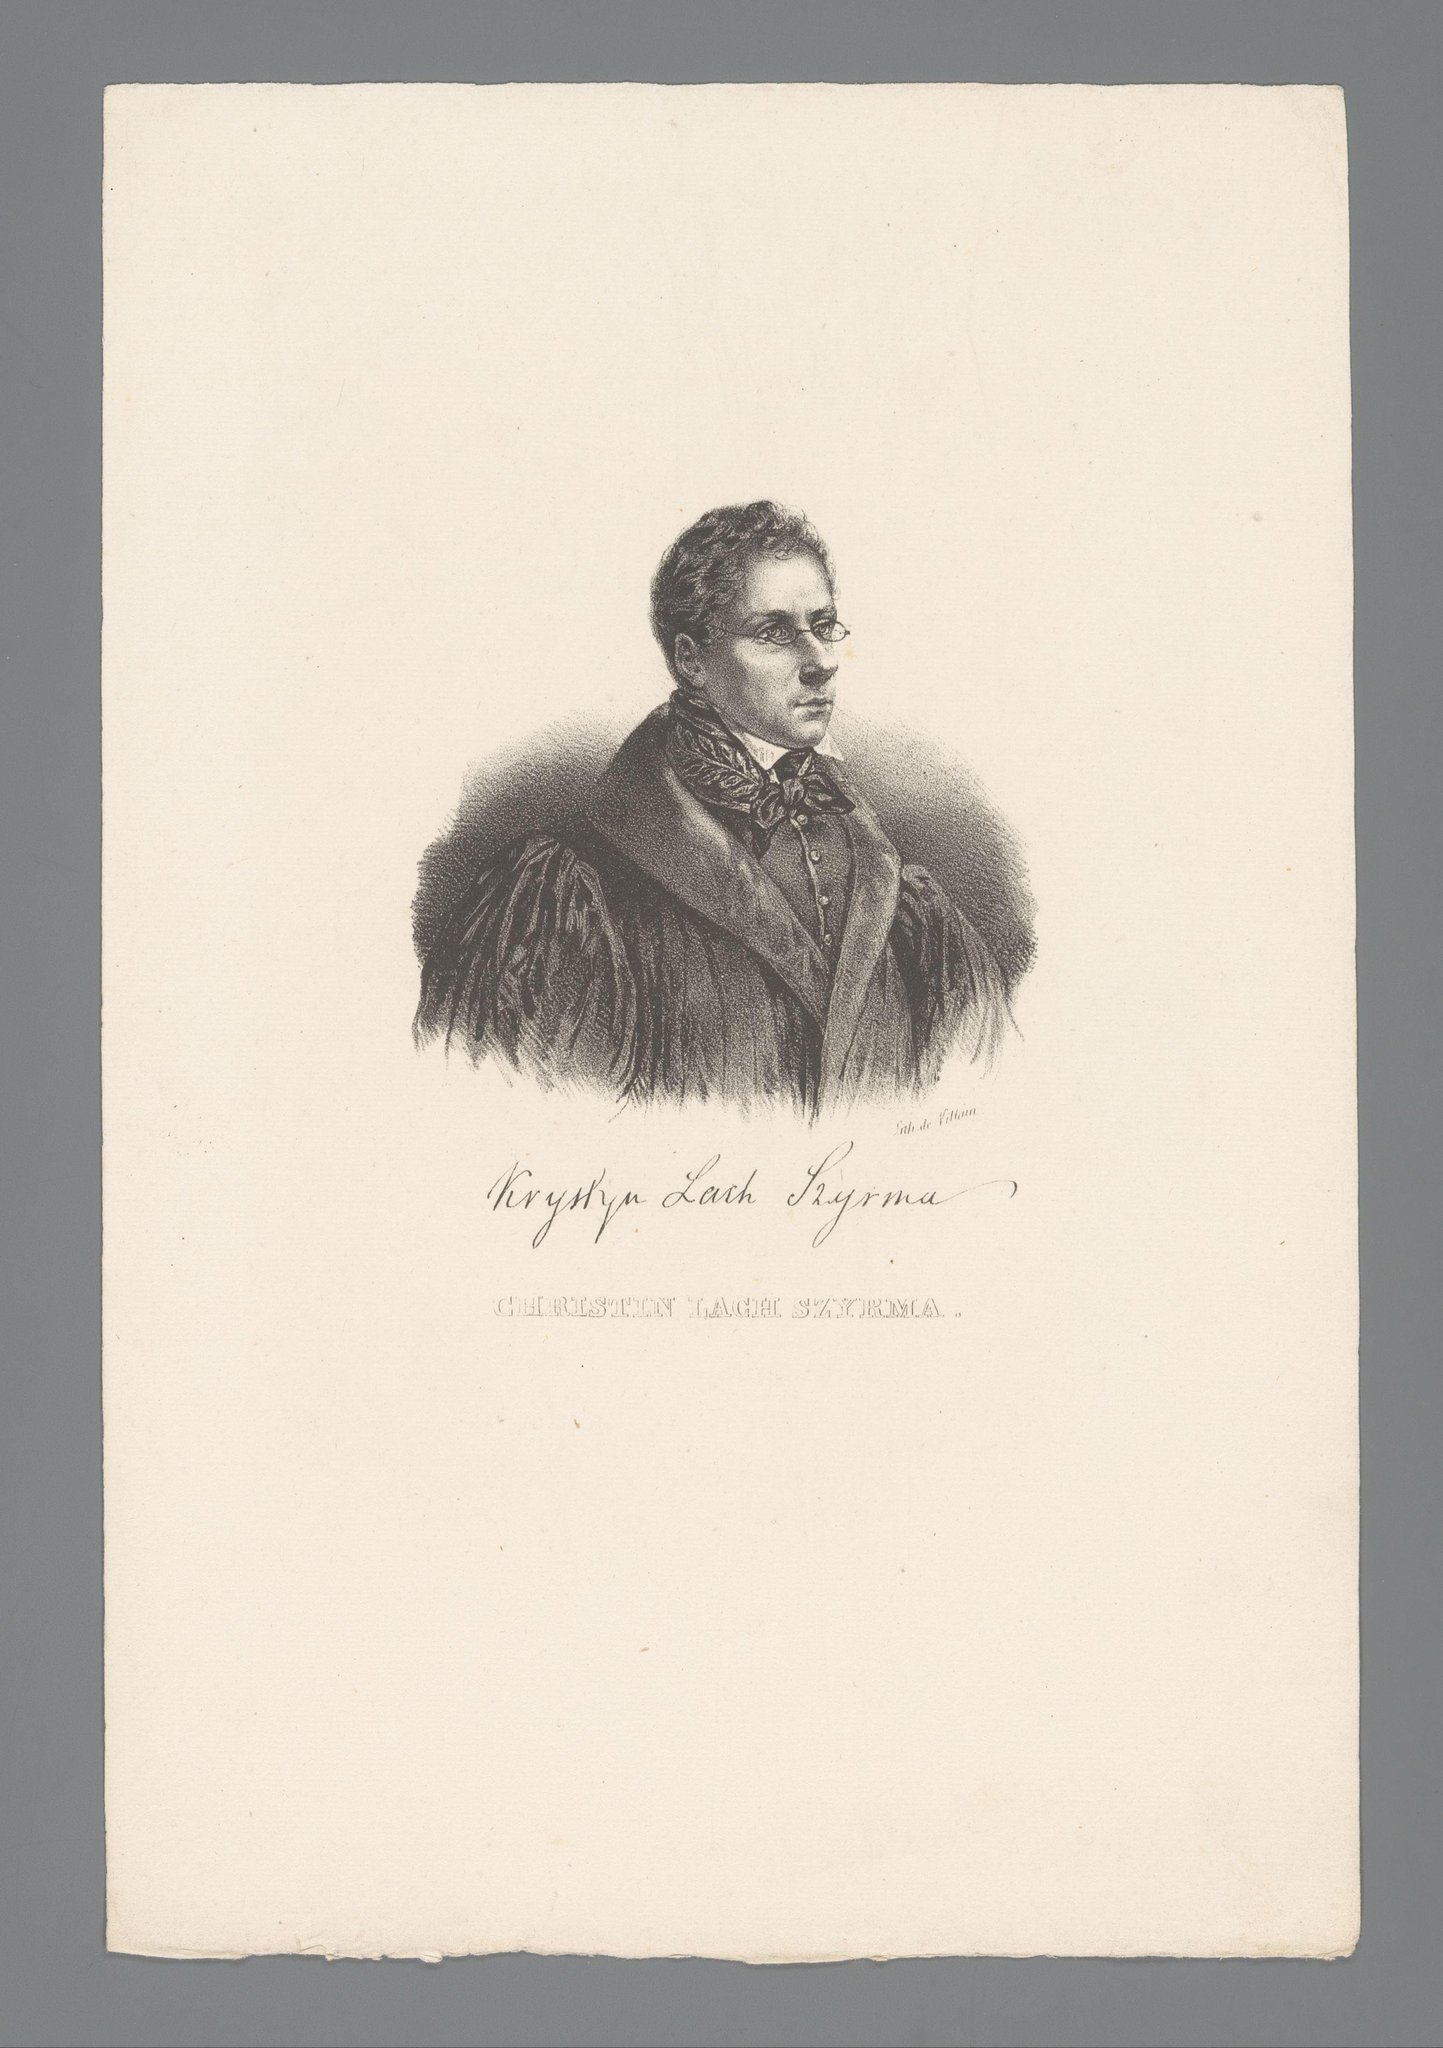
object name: print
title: Portret van Krystyn Lach Szyrma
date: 1832-1839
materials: paper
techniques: lithograph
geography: paris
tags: historical persons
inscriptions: collector's mark: Lugt 2228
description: Prent uit: Straszewicz., Joseph. Les polonais et les polonaises de la révolution du 29 novembre 1830, ou Portraits des personnes qui ont figuré dans la dernière guerre de l'indépendance polonaise, avec les fac-simile de leur signature, lithographiés sur dessins originaux, par les artistes les plus distingués: MM. Grévedon, Maurin, Vigneron, Belliard, Devéria, Bazin, Desmadryl, Lecler, Desmaisons, Rutowski, officier polonais, etc,. etc., accompagnés d'une biographie pour chaque portrait. Parijs: Catherine-Anaïs Pinard, 1832. Of uit: Straszewicz., Joseph. Les polonais et les polonaises de la révolution du 29 novembre 1830. Biographie des personnes qui ont figuré dans la dernière guerre de l'indépendance polonaise, avec les fac-simile de leur signature, ornée de 30 portraits lithographiés sur dessins originaux, par les artistes les plus distingués: MM. Grévedon, Maurin, Vigneron, Belliard, Devéria, Bazin, Desmadryl, Lecler, etc., etc.. Parijs: s.n., 1839.